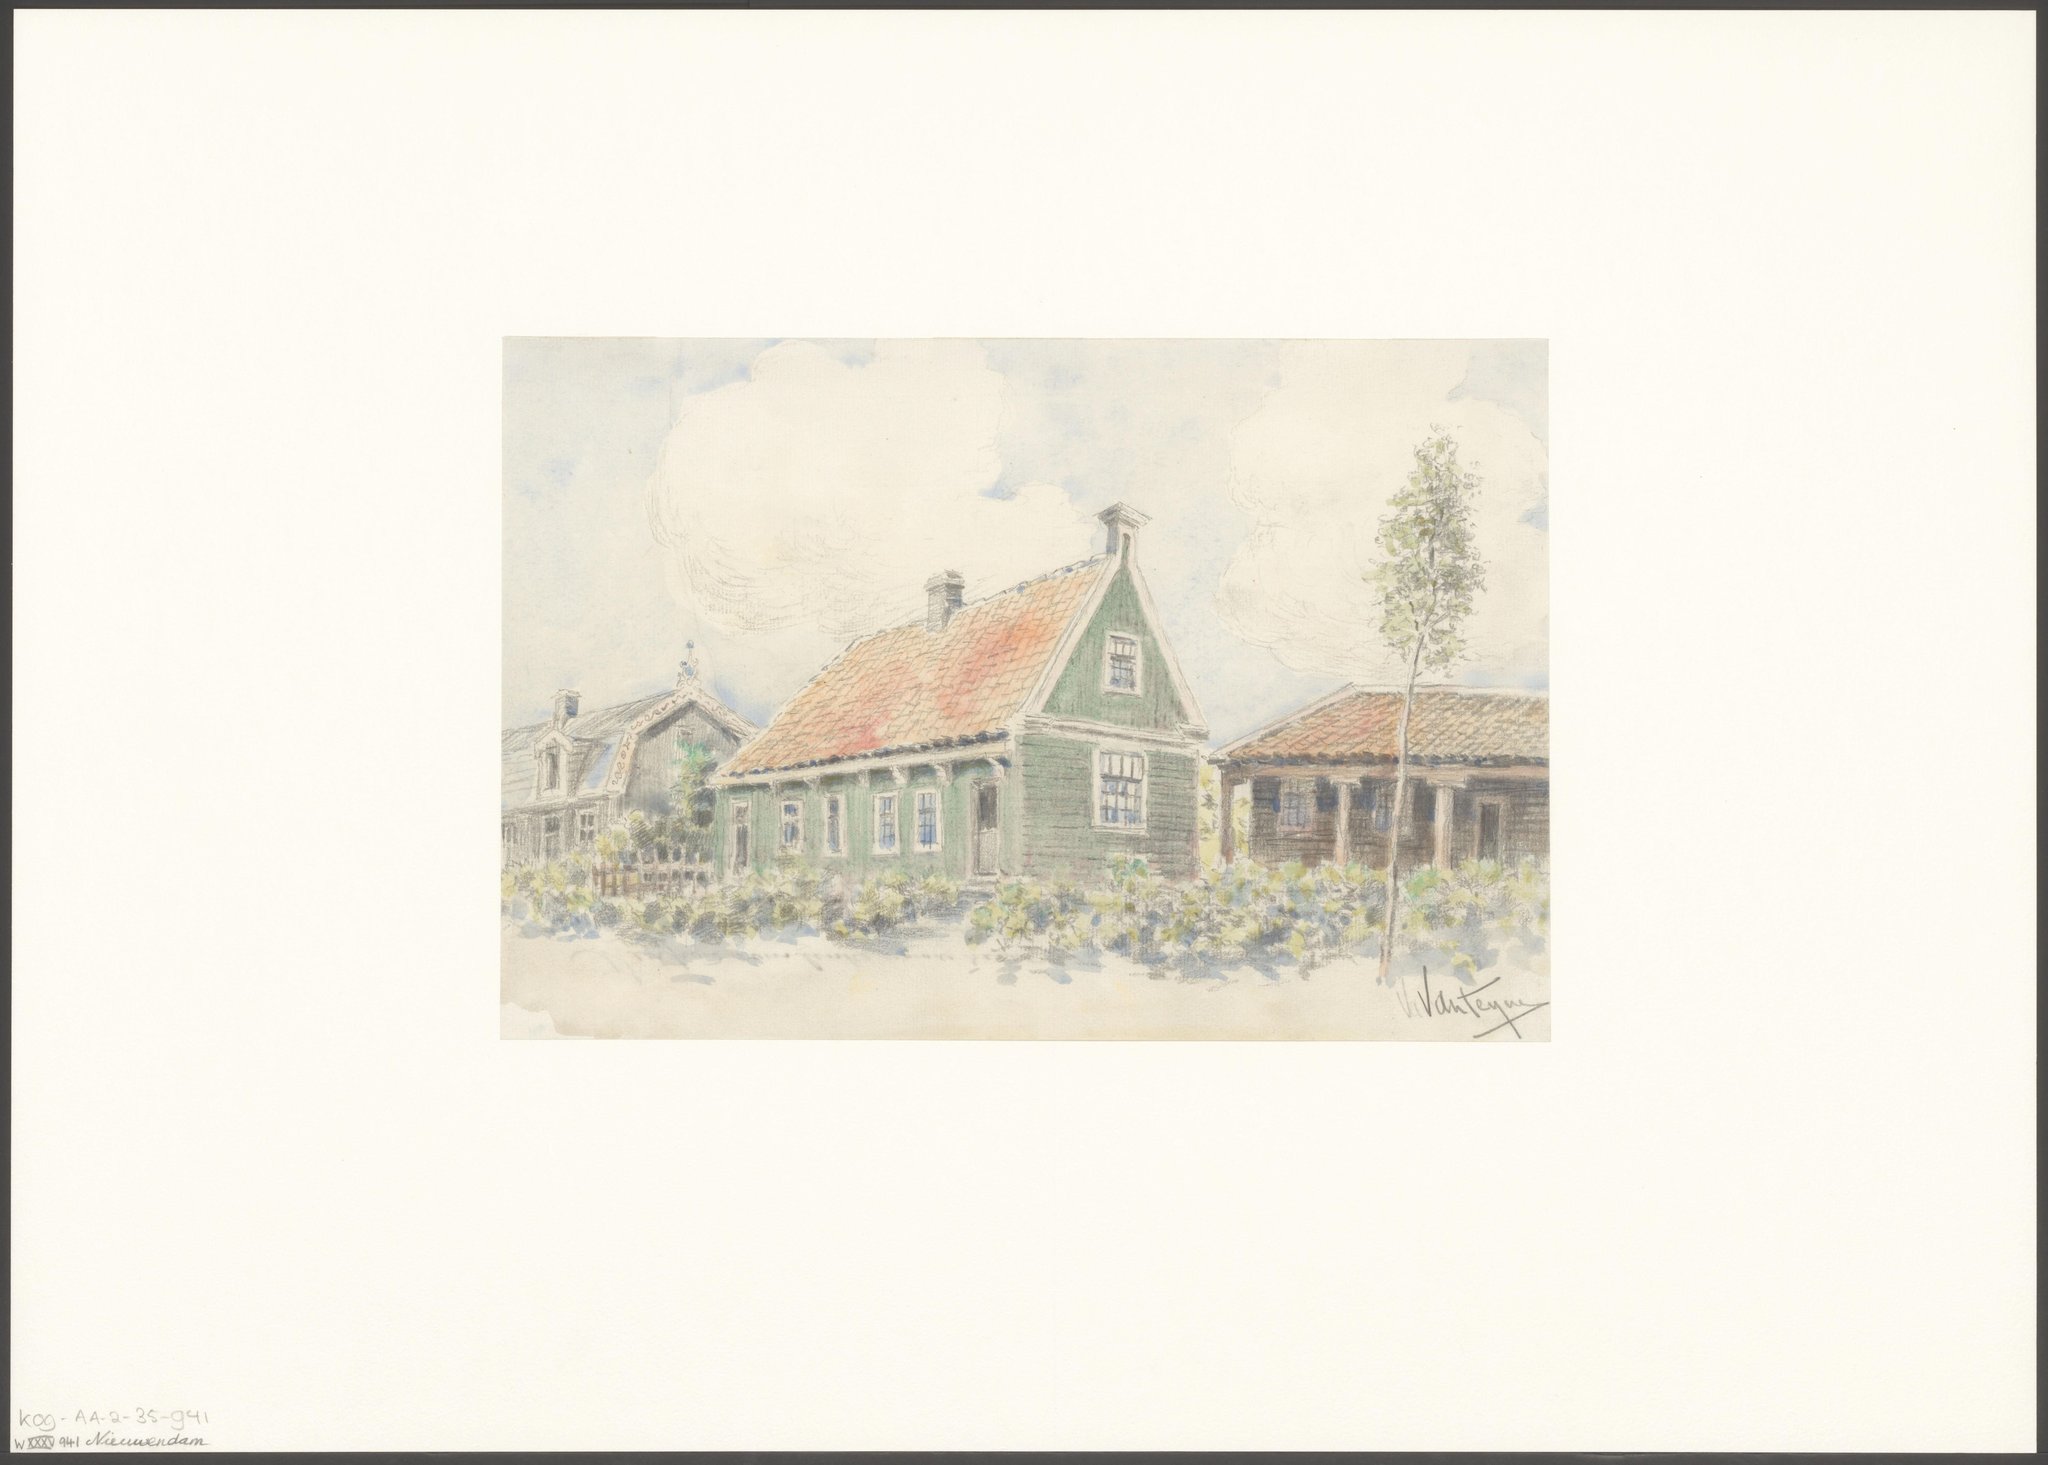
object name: drawing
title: Gezicht op huizen te Nieuwendam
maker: anthonie van teijn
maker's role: draughtsman, painter, print maker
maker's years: 1863-1943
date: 1906-1928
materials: chalk, paper, watercolor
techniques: brush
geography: amsterdam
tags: village, road, path, farm or solitary house in landscape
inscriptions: signature: ‘VanTeyne’, inscription: ‘Meerpon (?) van links (...) baksteen. / vanEck’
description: Tekening binnen de Atlas Van Eck ingedeeld op wijknummer 35.